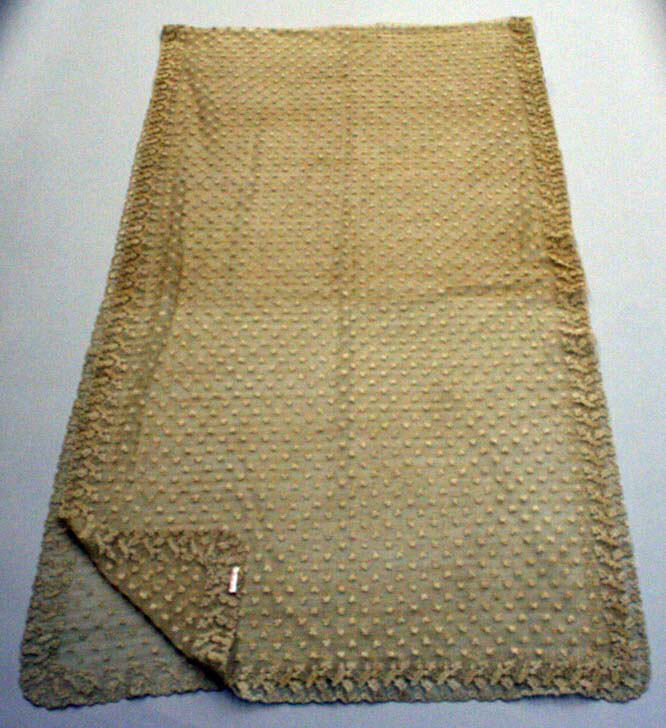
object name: scarf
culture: italian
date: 1867-1900